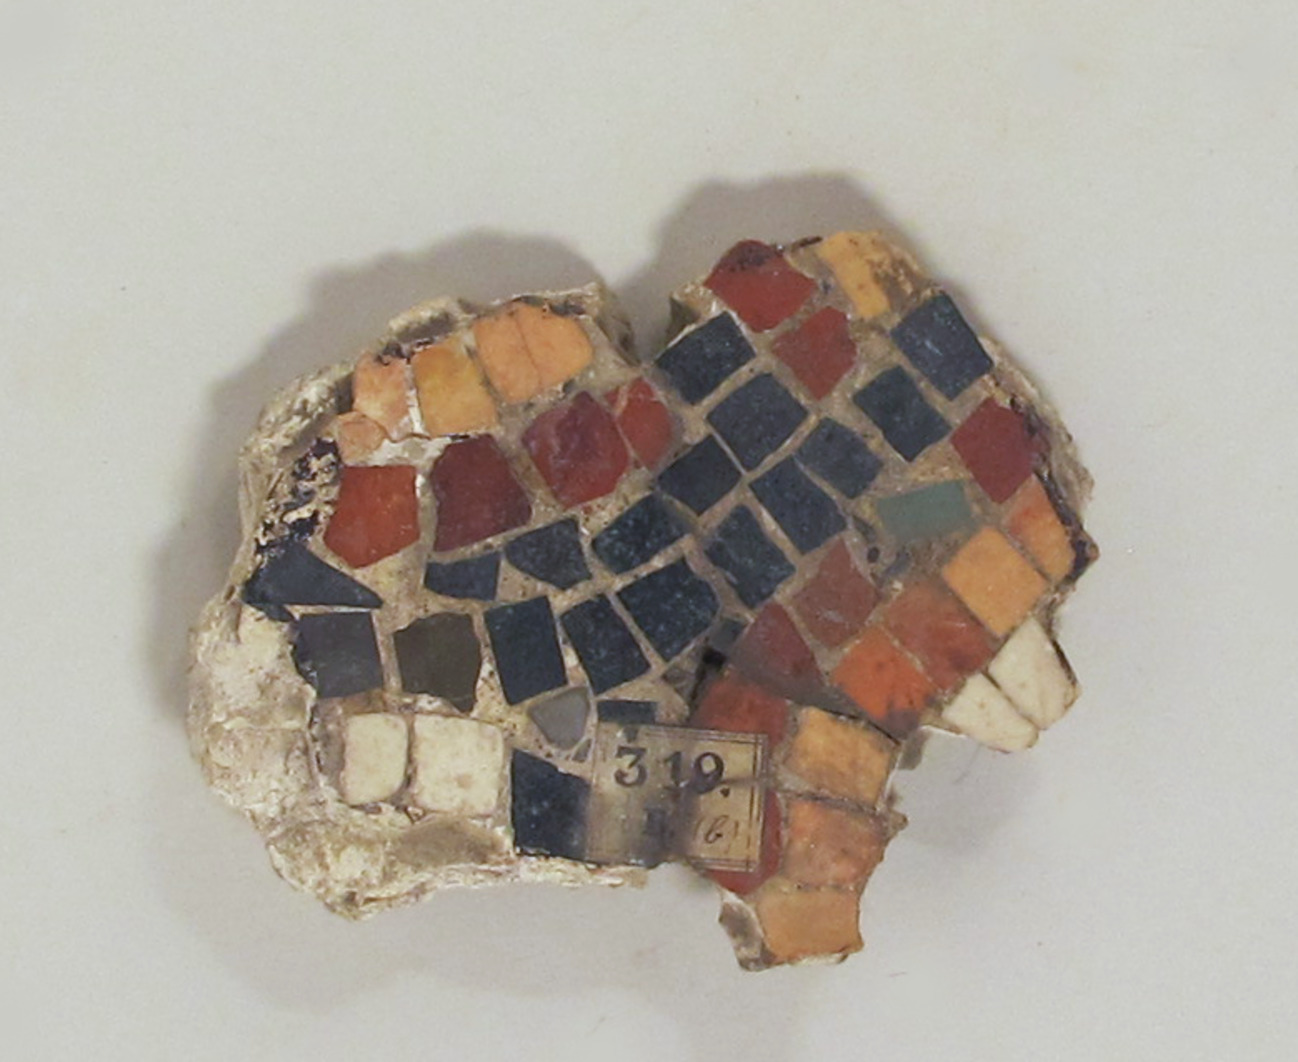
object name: mosaic pavement fragment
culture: roman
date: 670 BCE-330 CE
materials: mortar